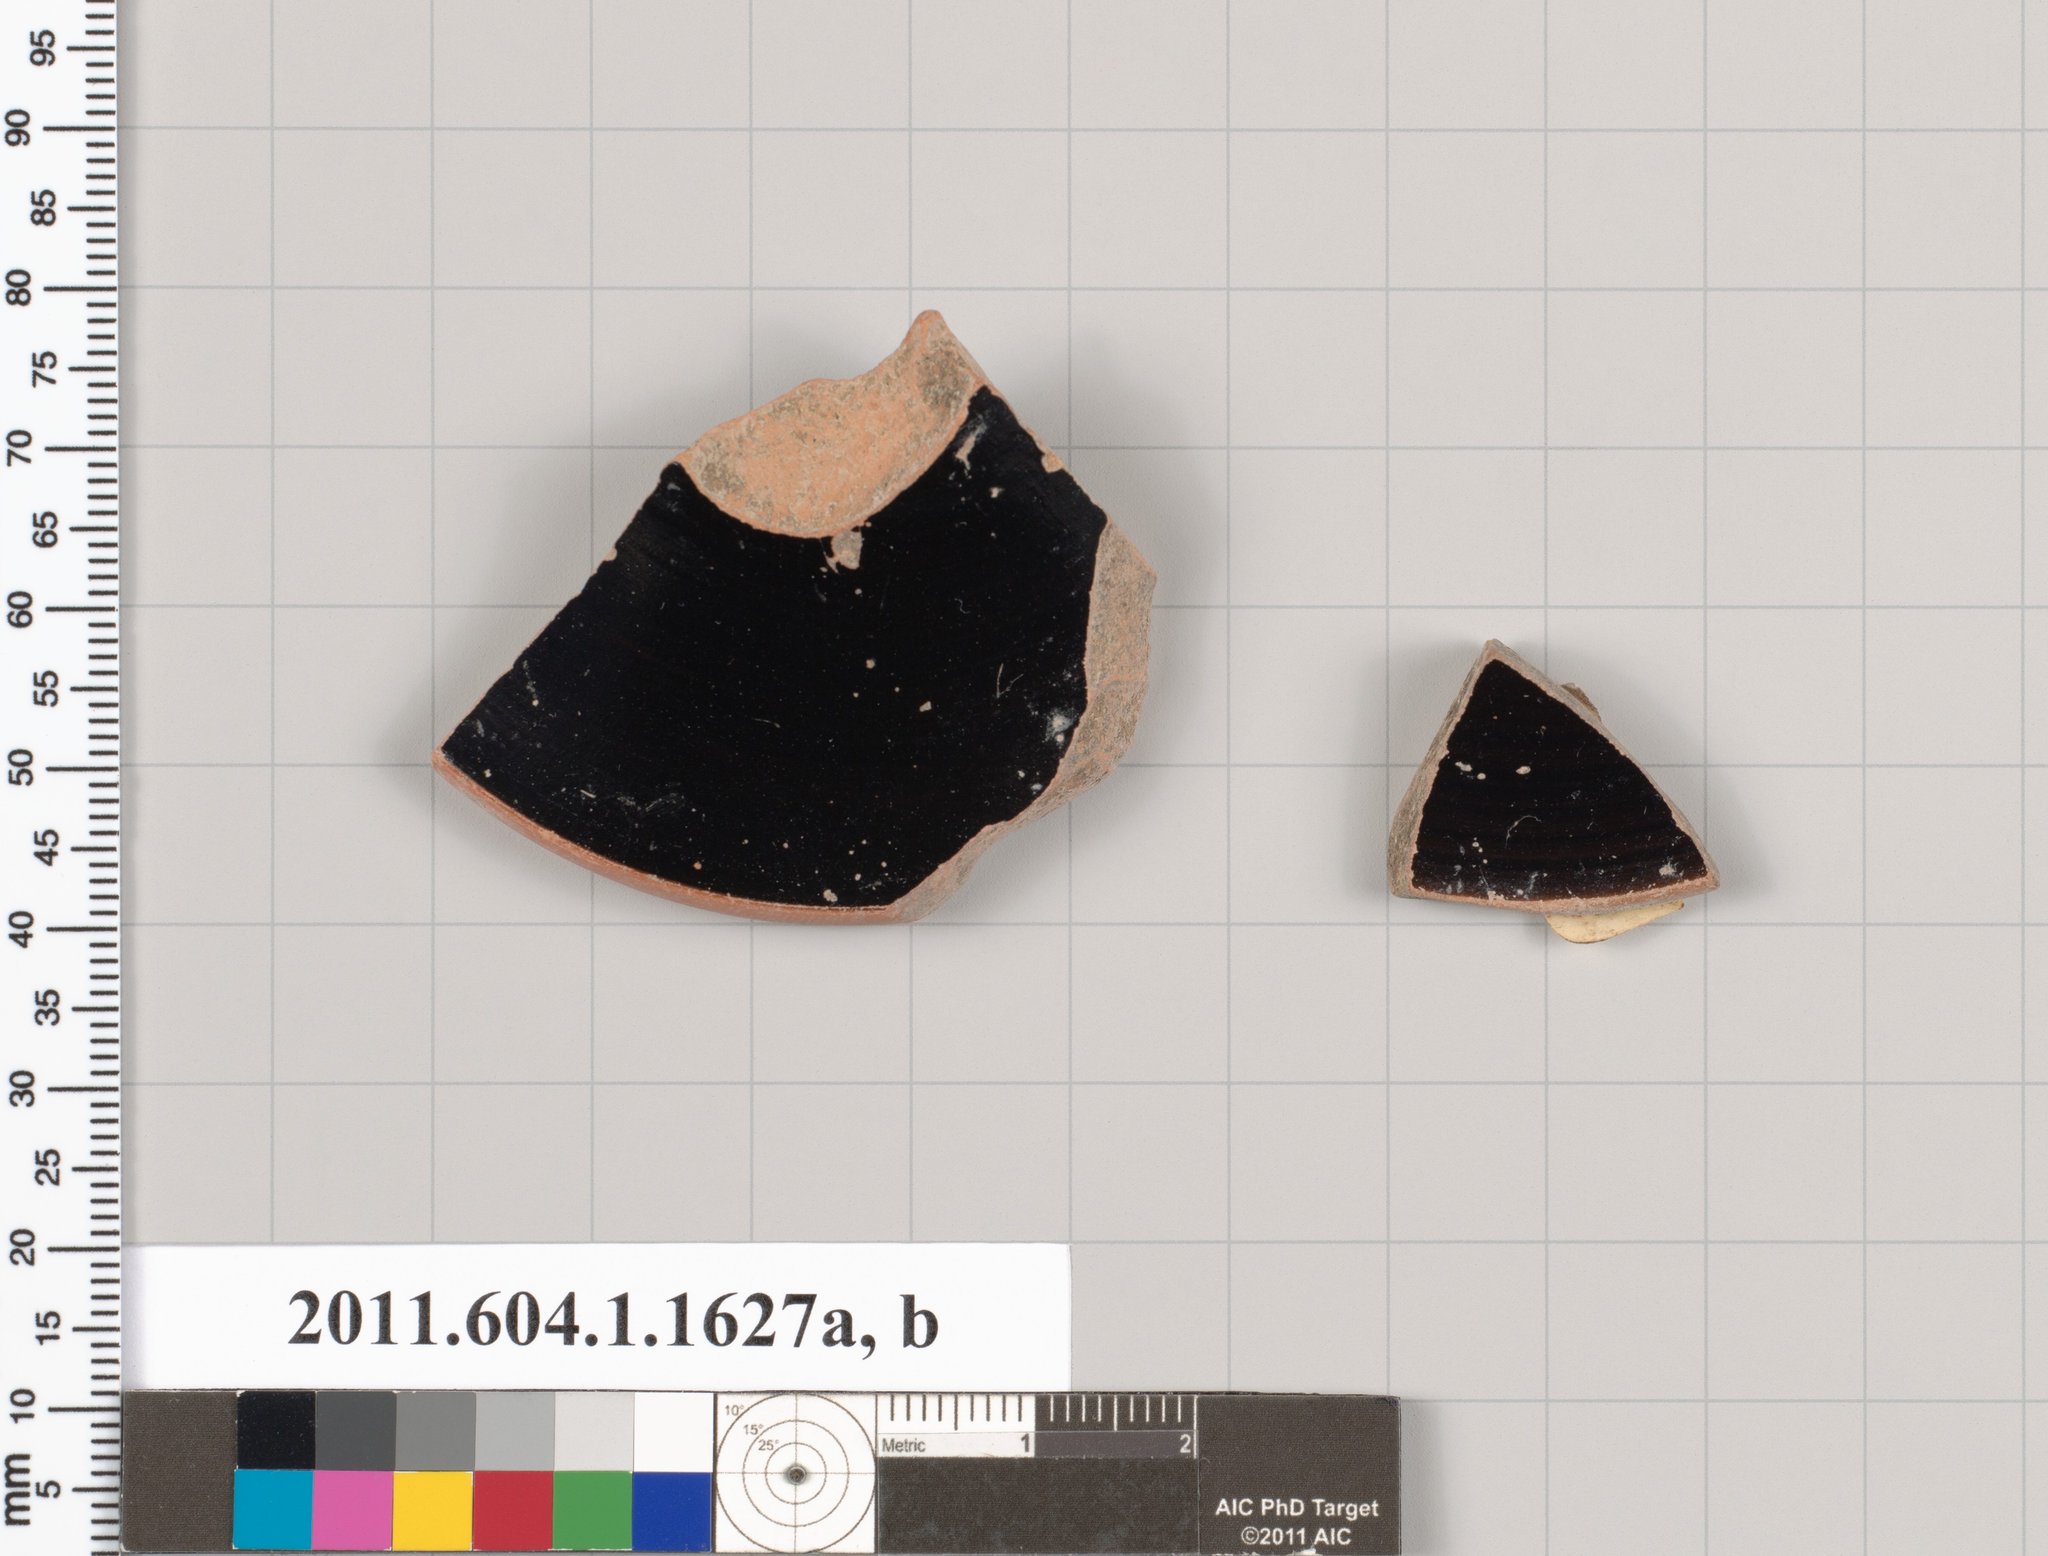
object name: kylix fragment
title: Terracotta fragments of kylikes (drinking cups)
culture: greek, attic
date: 500-401 BCE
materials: terracotta